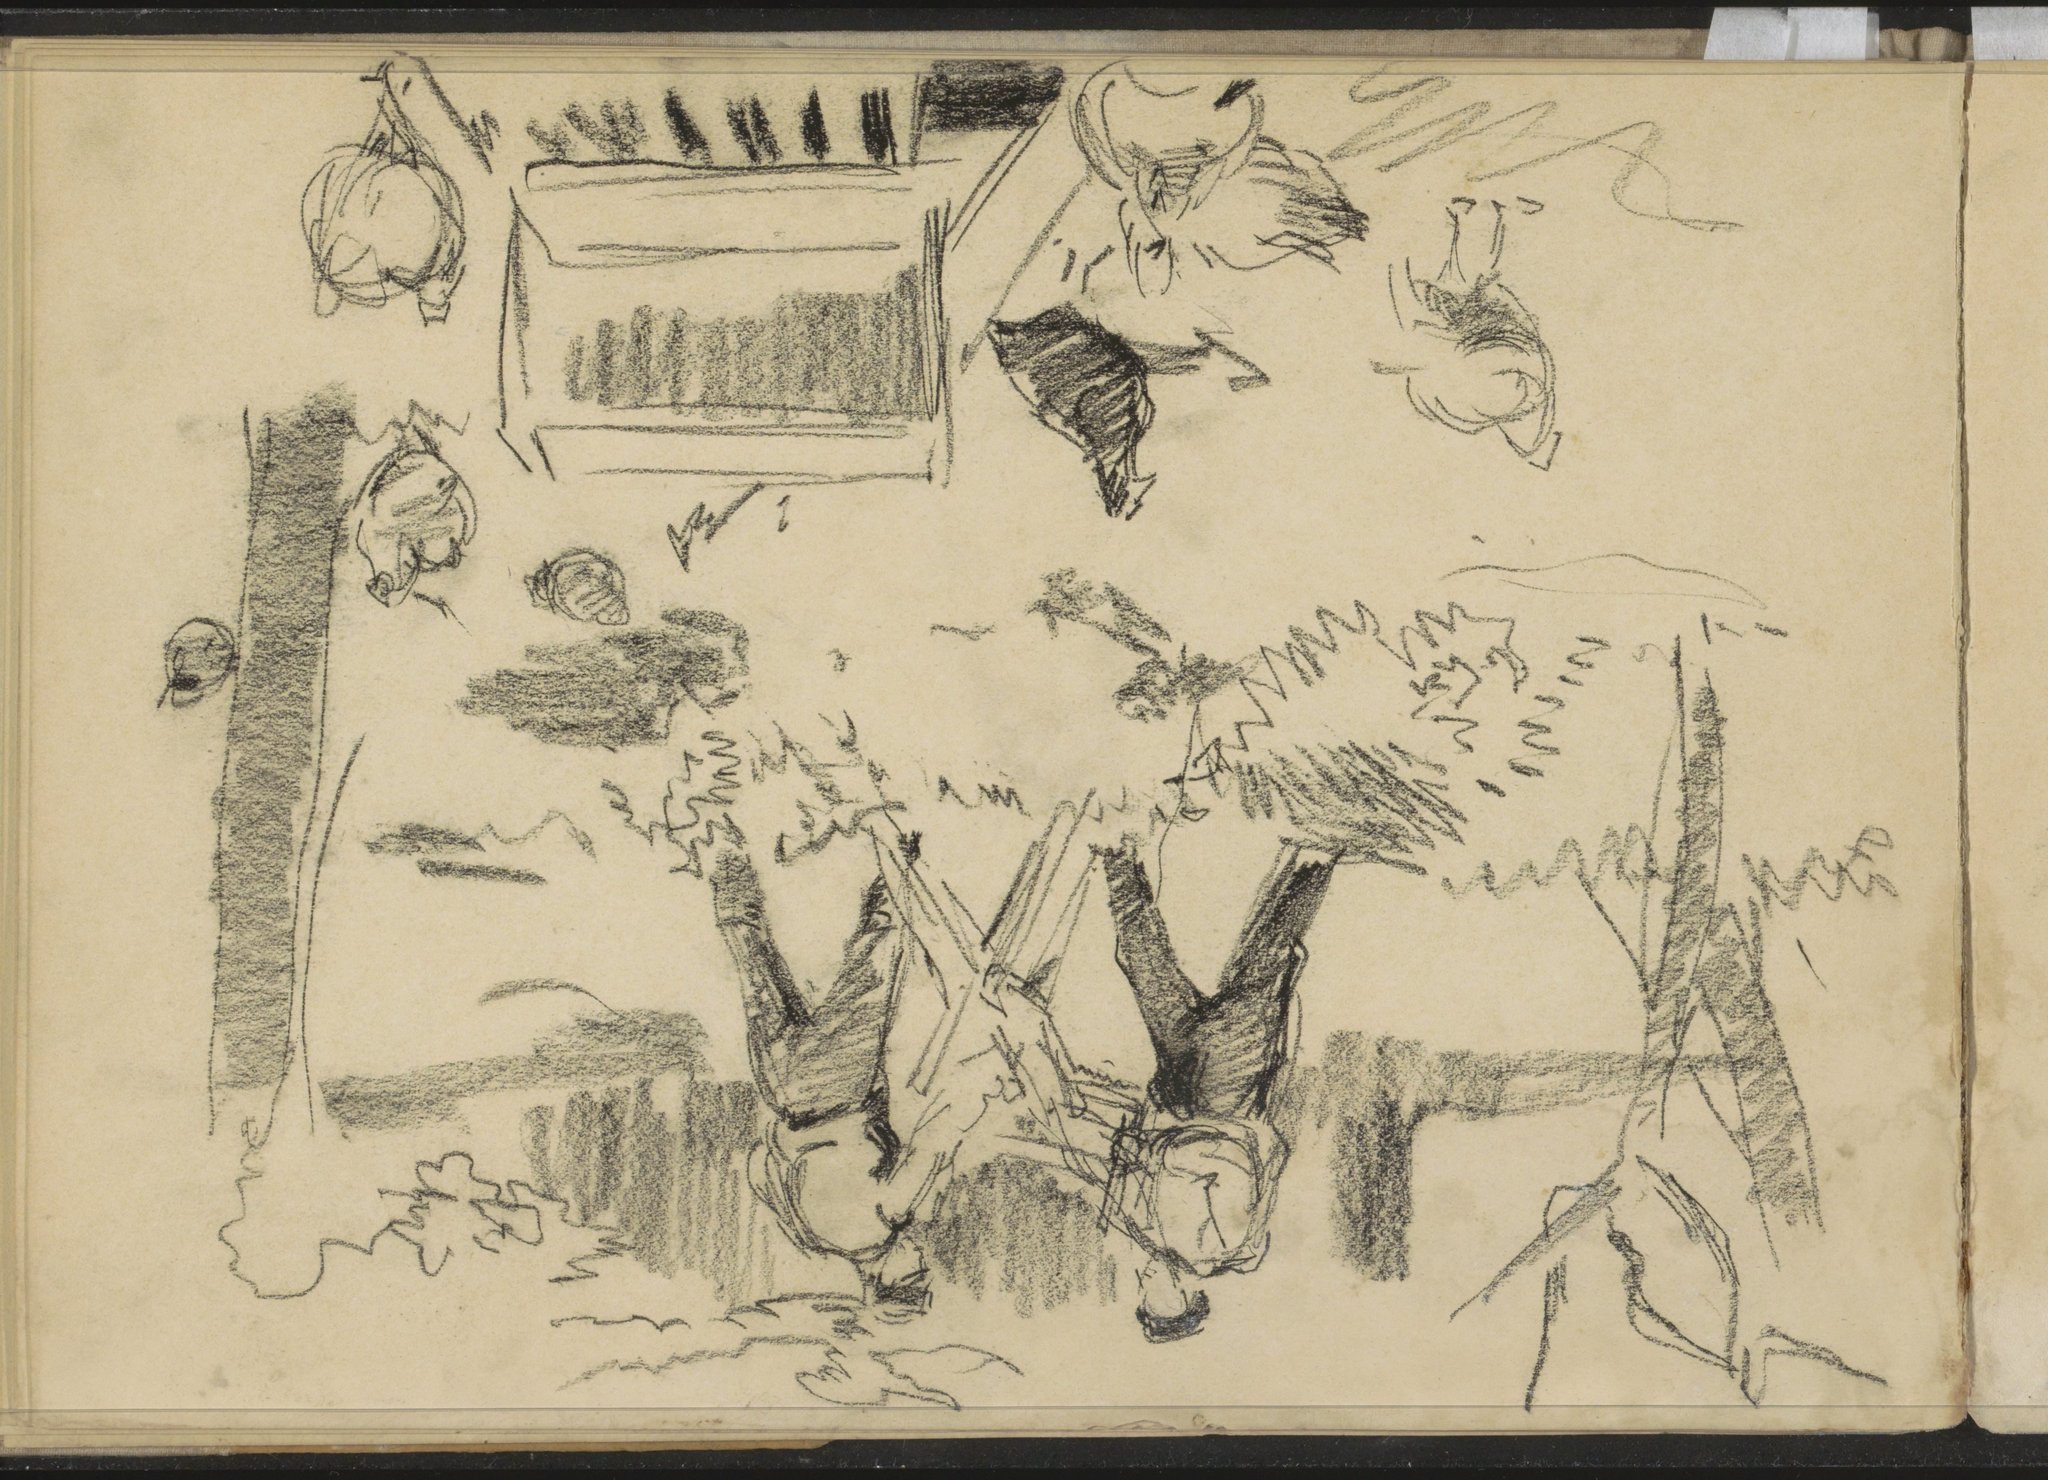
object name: sketchbook leaf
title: Twee mannen die hout zagen in een weiland, kippen en een kleine piano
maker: willem bastiaan tholen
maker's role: draughtsman, painter, print maker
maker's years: 1860-1931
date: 1885-1931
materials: chalk, paper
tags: grand piano, adult man, meadow, pasture, fowl (cock, hen, chicken, etc.), tools, aids, implements ~ crafts and industries: saw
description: Blad 21 verso uit een schetsboek met 28 bladen.